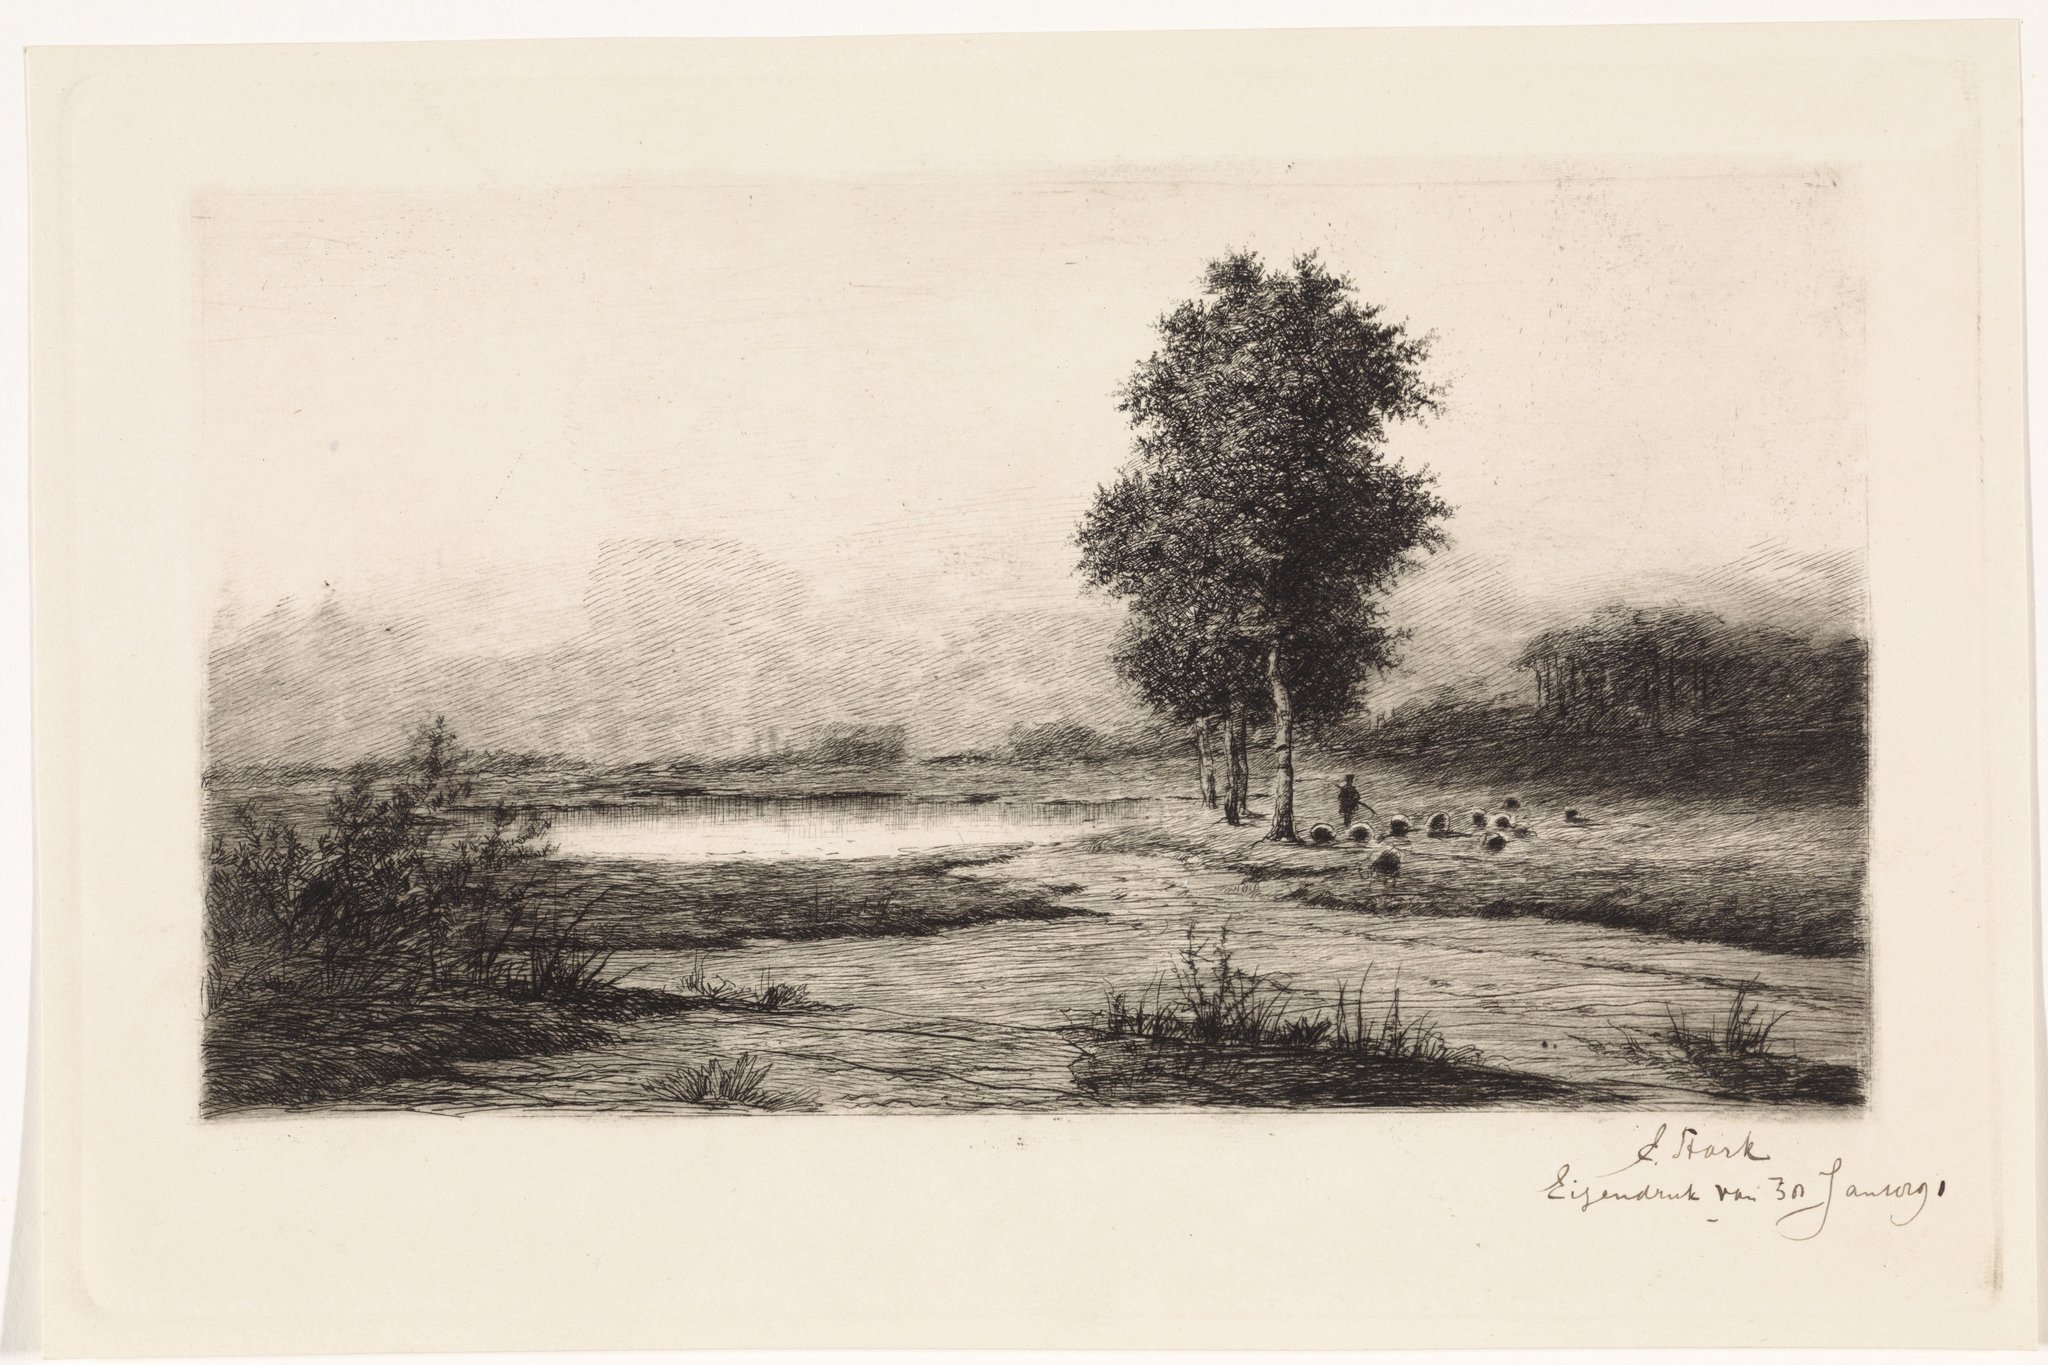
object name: print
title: Landschap met waterplas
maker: elias stark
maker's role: draughtsman, print maker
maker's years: 1849-1933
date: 1891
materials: paper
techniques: etching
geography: nieuwer-amstel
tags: herding, herdsman, herdswoman, shepherd, shepherdess, cowherd, etc., pond, pool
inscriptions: collector's mark: Lugt 2228, inscription: ‘E. Stark Eigendruk van 30 January’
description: Landschap met een waterplas. Bij enkele bomen staat een herder met zijn schapen.